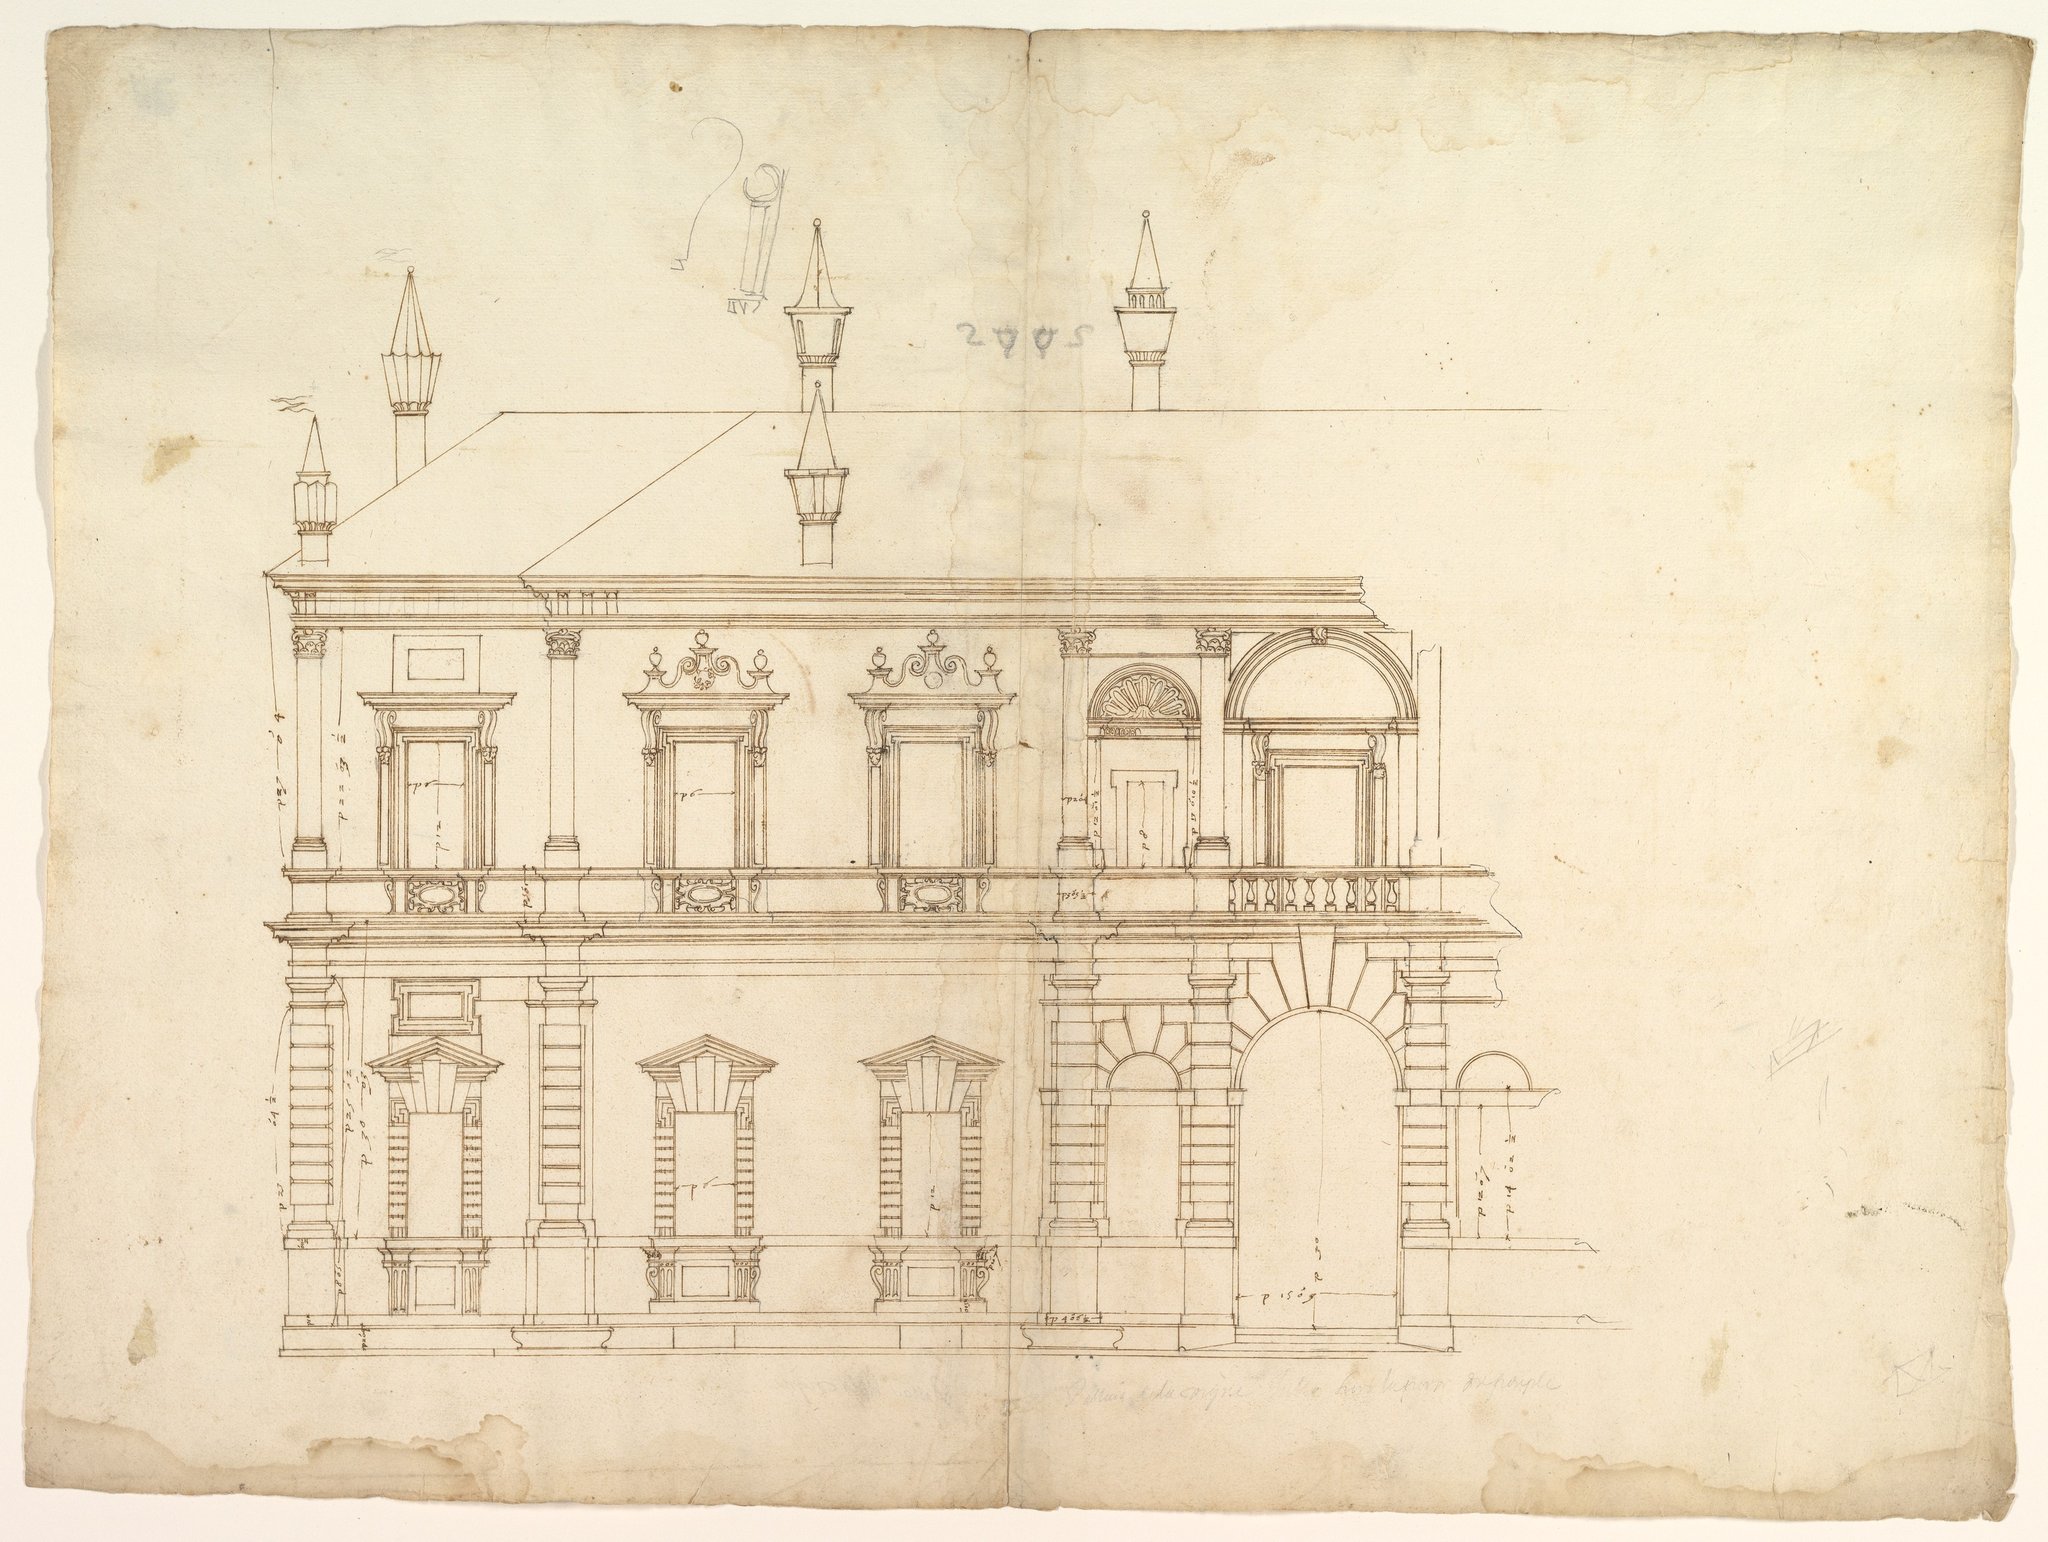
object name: drawing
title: Villa Giulia, Casino, elevation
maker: anonymous, french, 16th century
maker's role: draftsman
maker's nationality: french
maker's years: 1500-1600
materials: chalk, ink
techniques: incising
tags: architecture,buildings